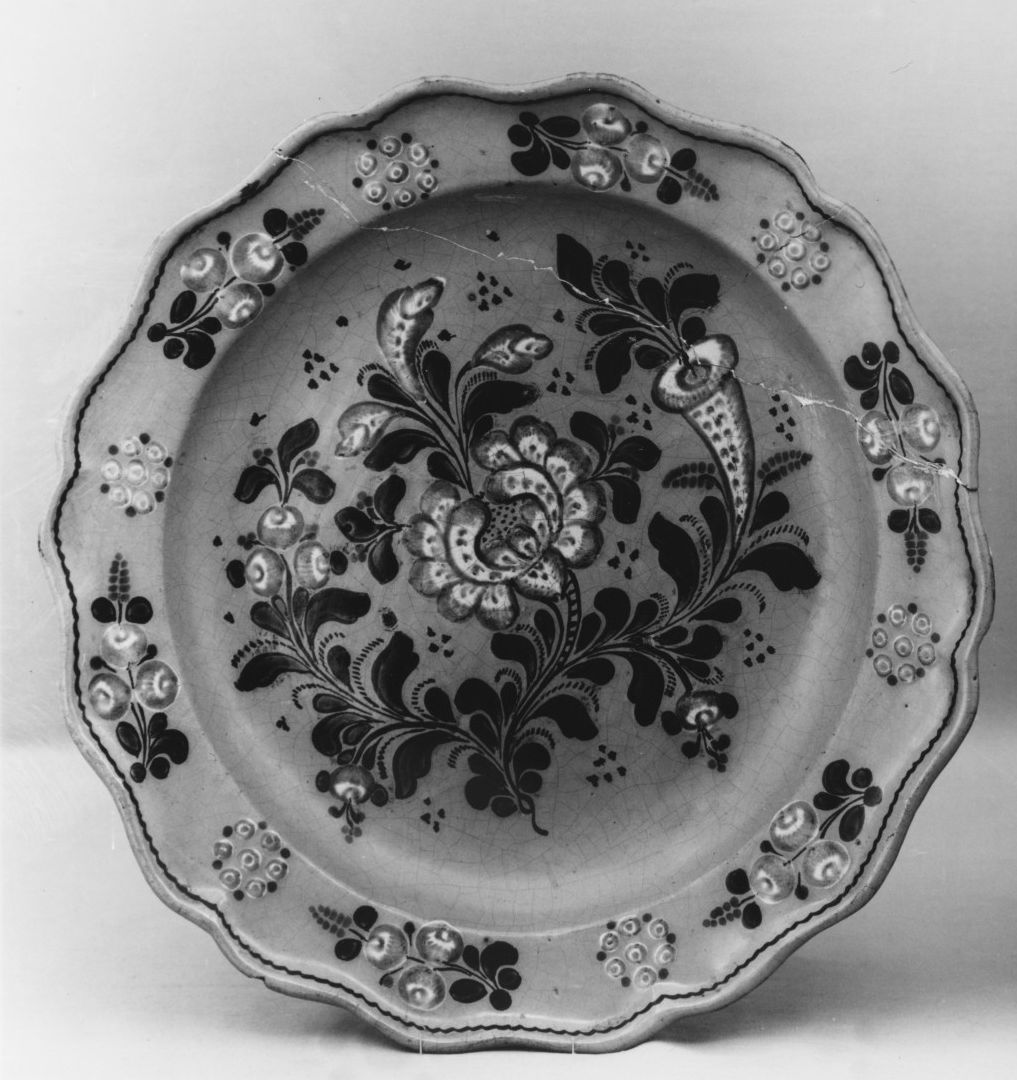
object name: plate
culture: mexican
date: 1830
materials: earthenware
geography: mexico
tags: flowers